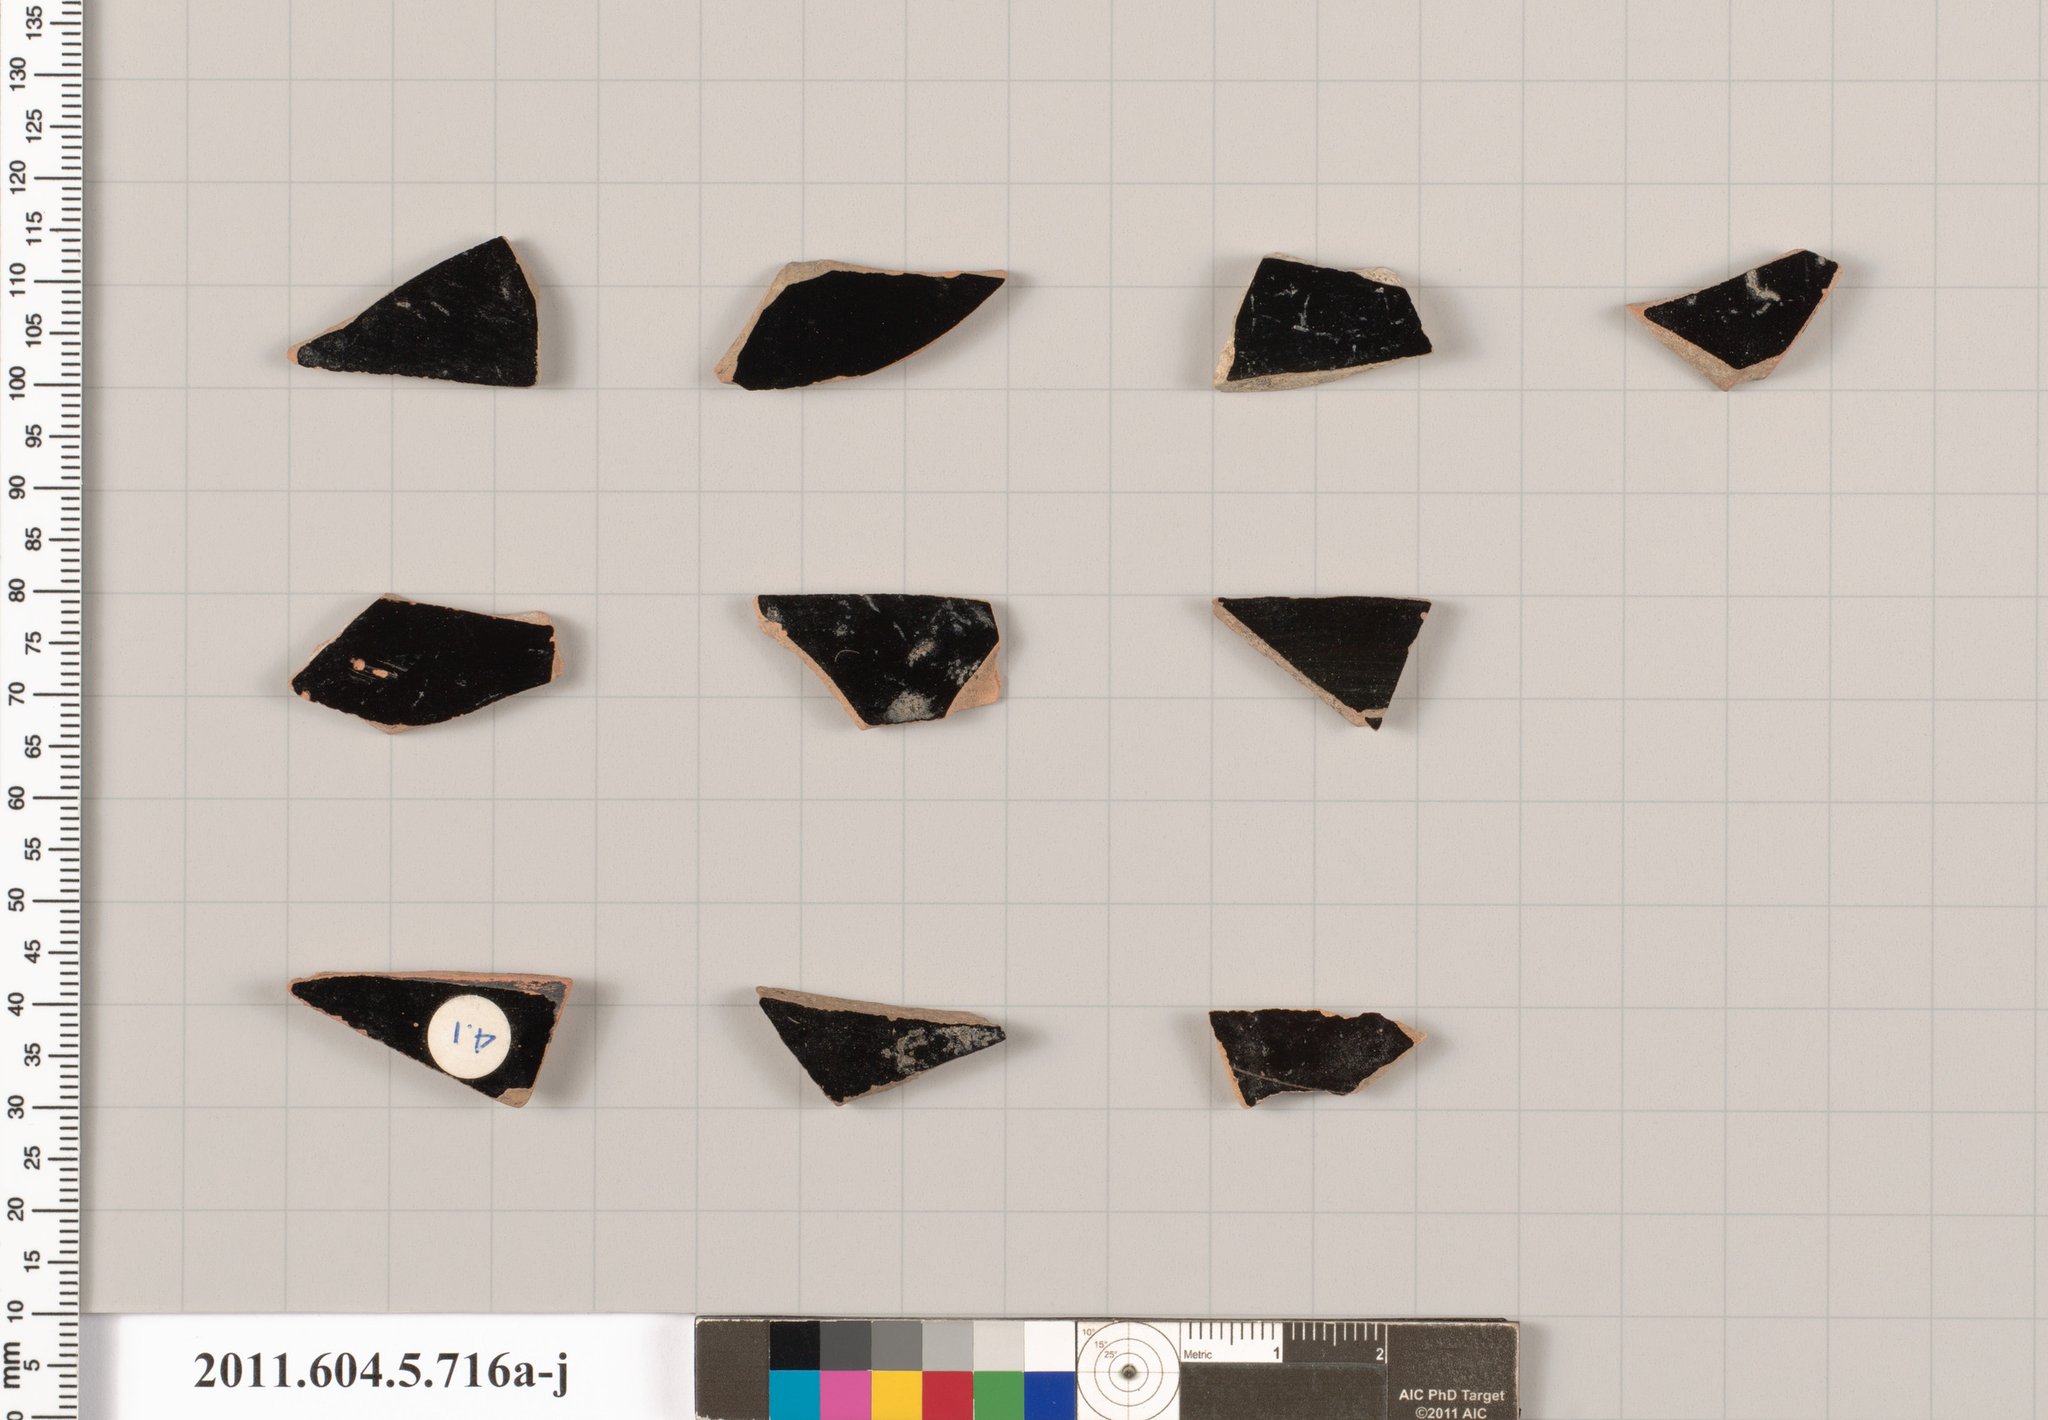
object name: kylix fragment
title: Terracotta fragments of kylikes (drinking cups)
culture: greek, attic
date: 600-401 BCE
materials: terracotta